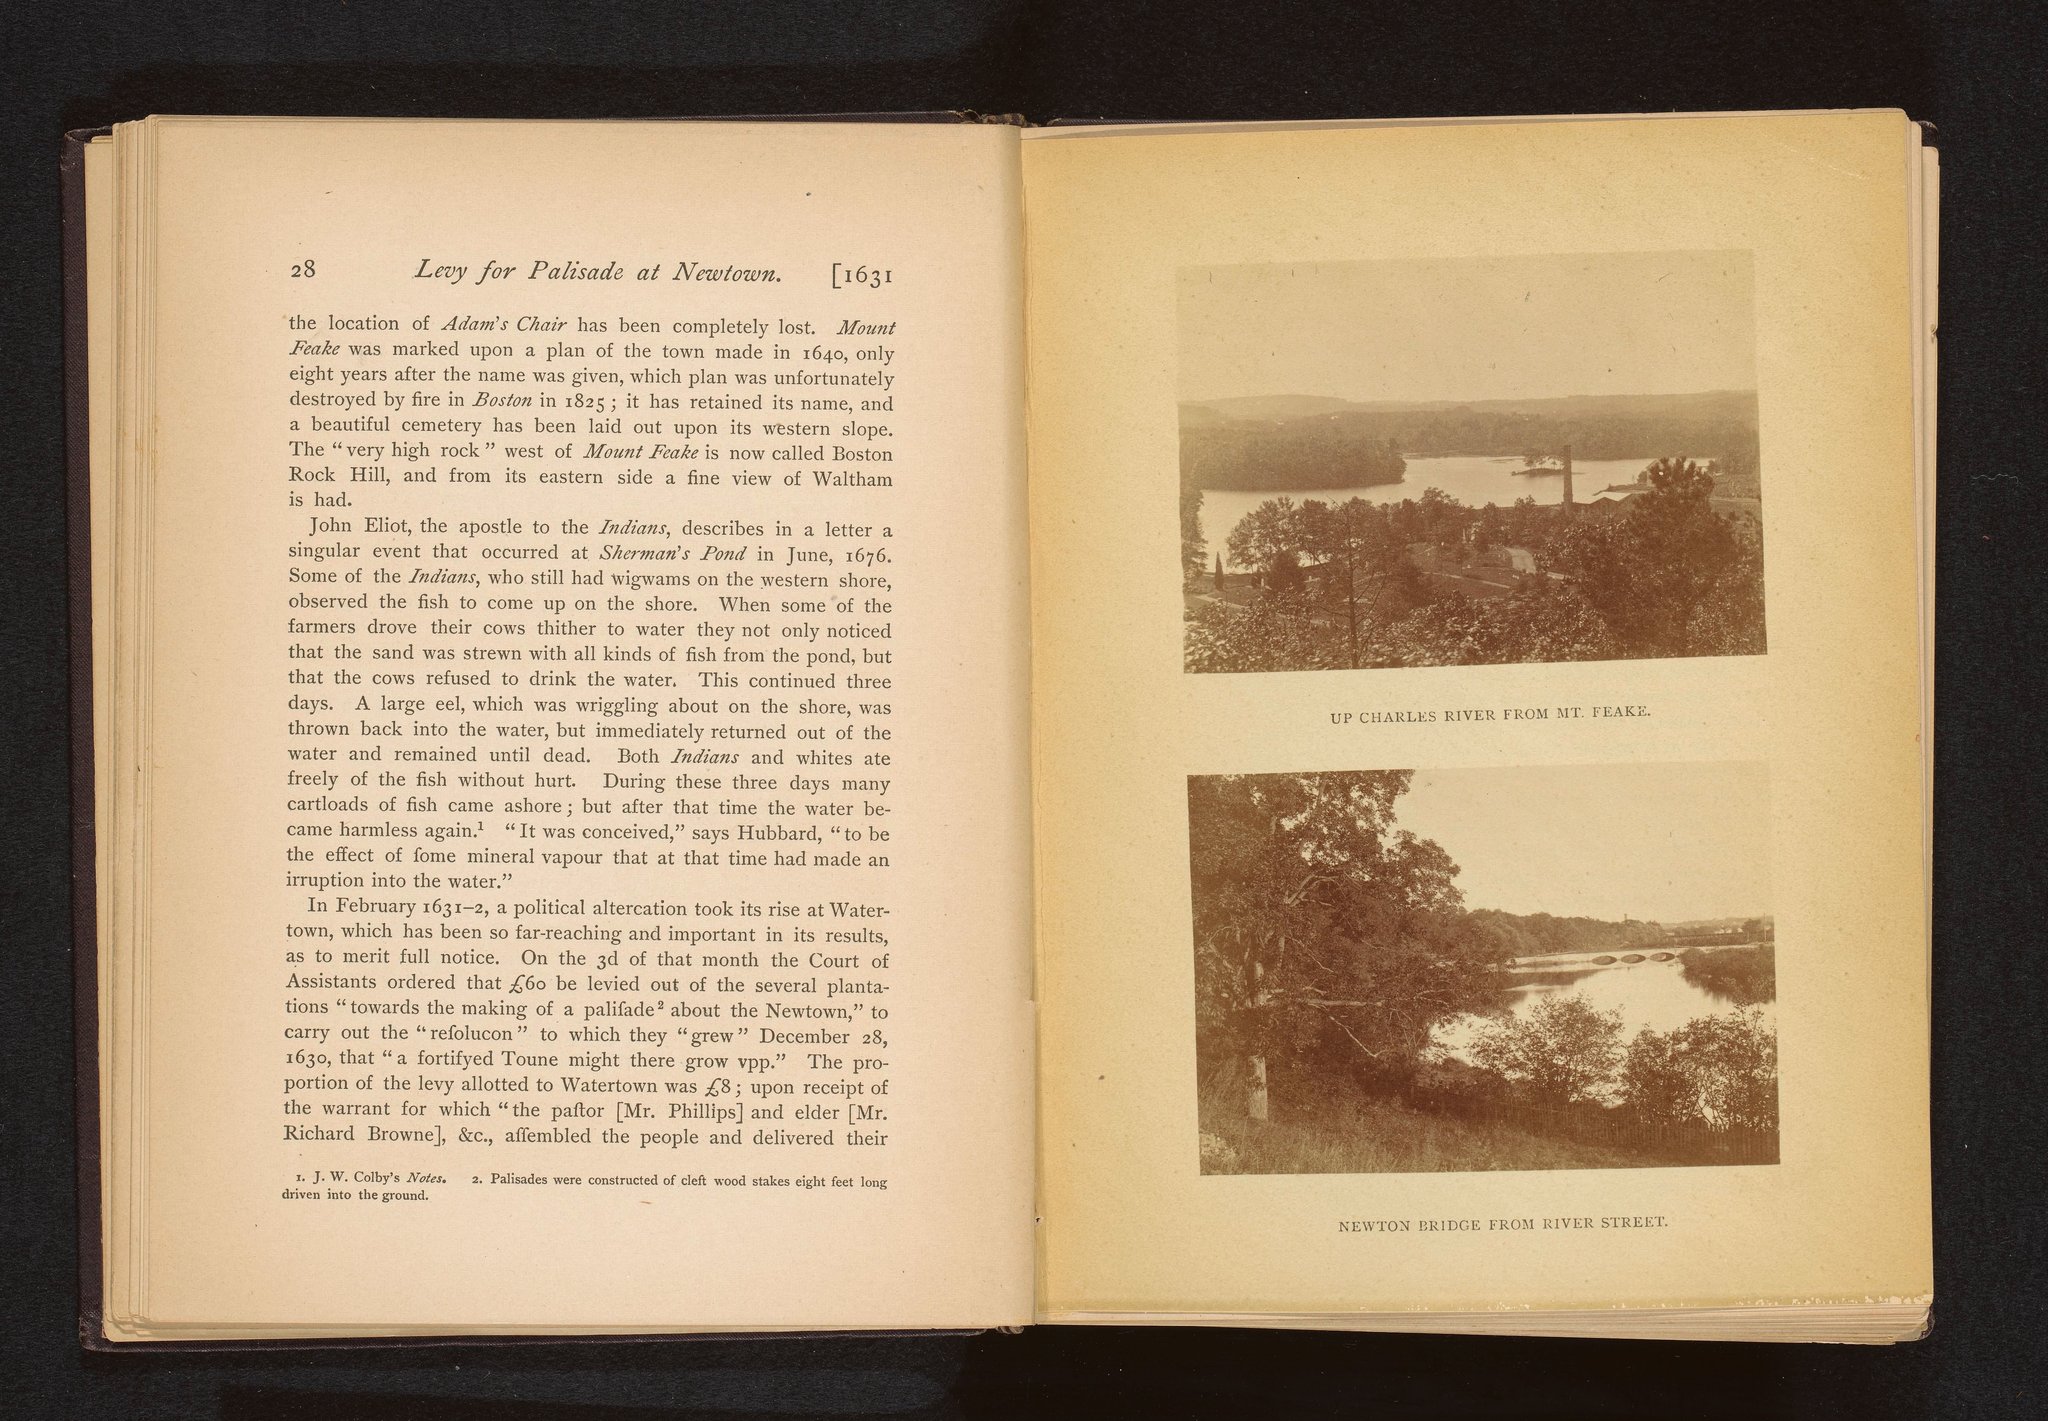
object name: page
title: Gezicht op een rivier in de buurt van Waltham, Massachusetts, gezien vanaf Mount Feake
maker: thomas r. lewis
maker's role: publisher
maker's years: 1845-1901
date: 1874-1879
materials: photographic support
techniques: albumen print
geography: mount feake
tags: river